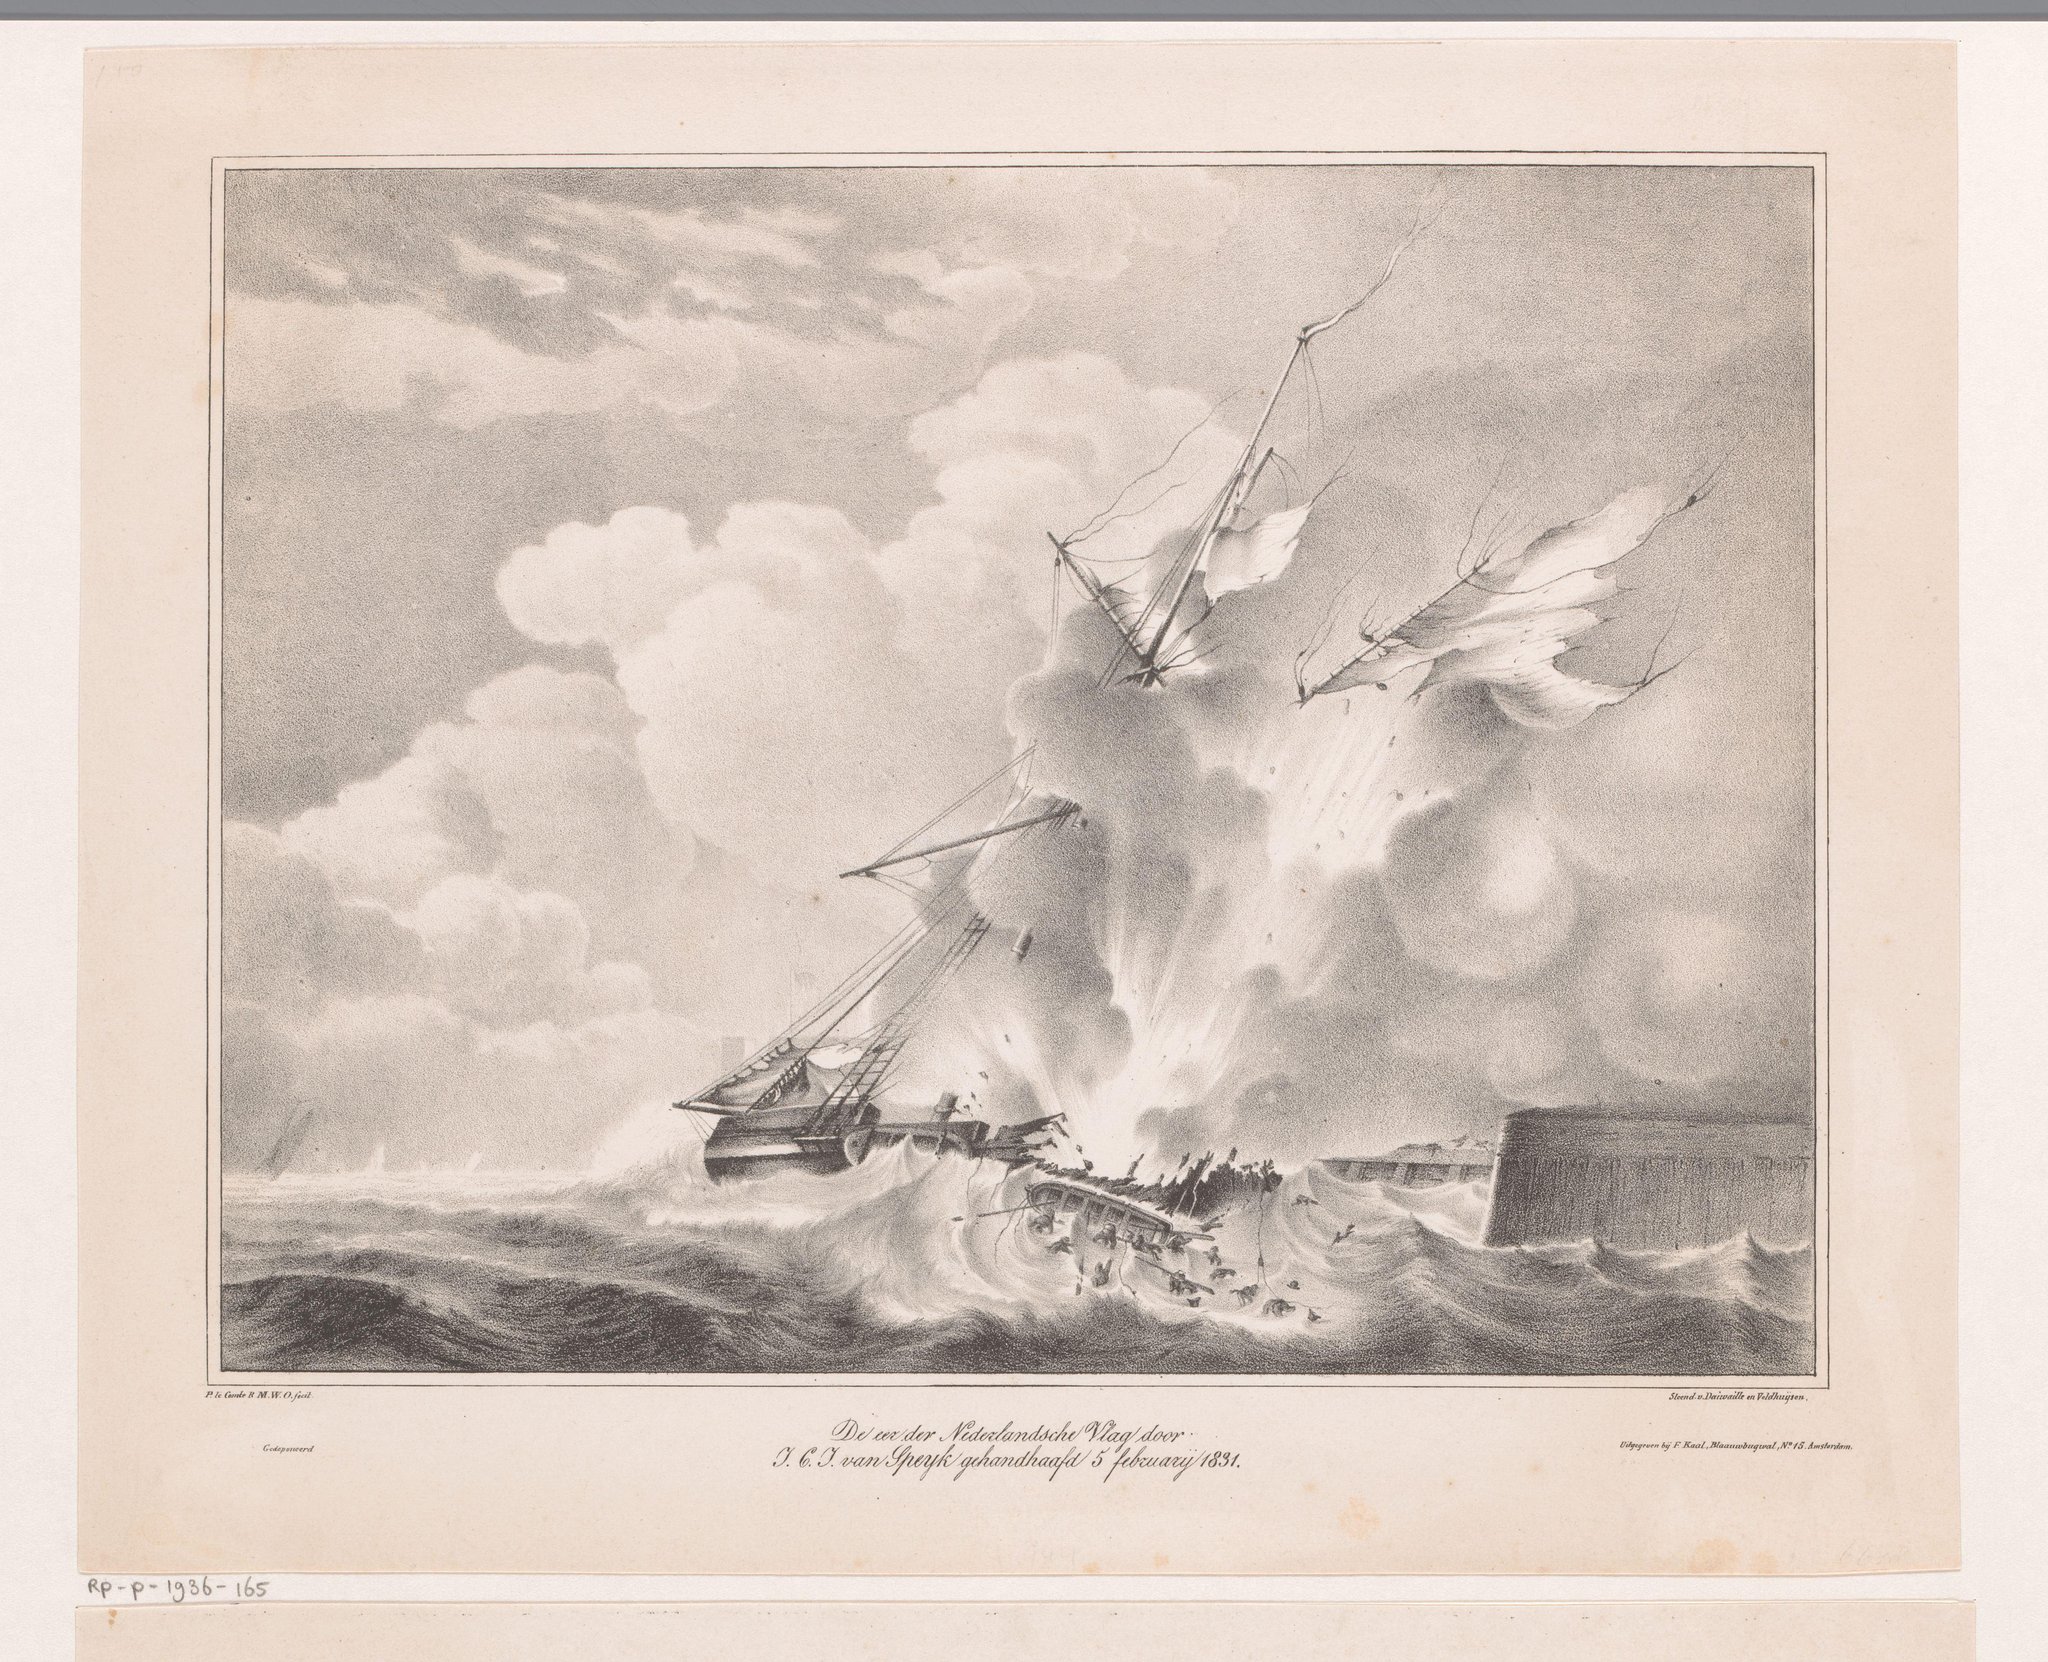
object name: print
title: De Eer der Nederlandsche vlag door J.C.J. van Speyk gehandhaafd, 5 Februarij 1831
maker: f. kaal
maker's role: publisher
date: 1831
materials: paper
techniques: lithograph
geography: amsterdam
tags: amsterdam, antwerp, jan van speyk, sailing-ship, sailing-boat, (military) attack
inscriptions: collector's mark: Lugt 2760, collector's mark: Lugt 2228